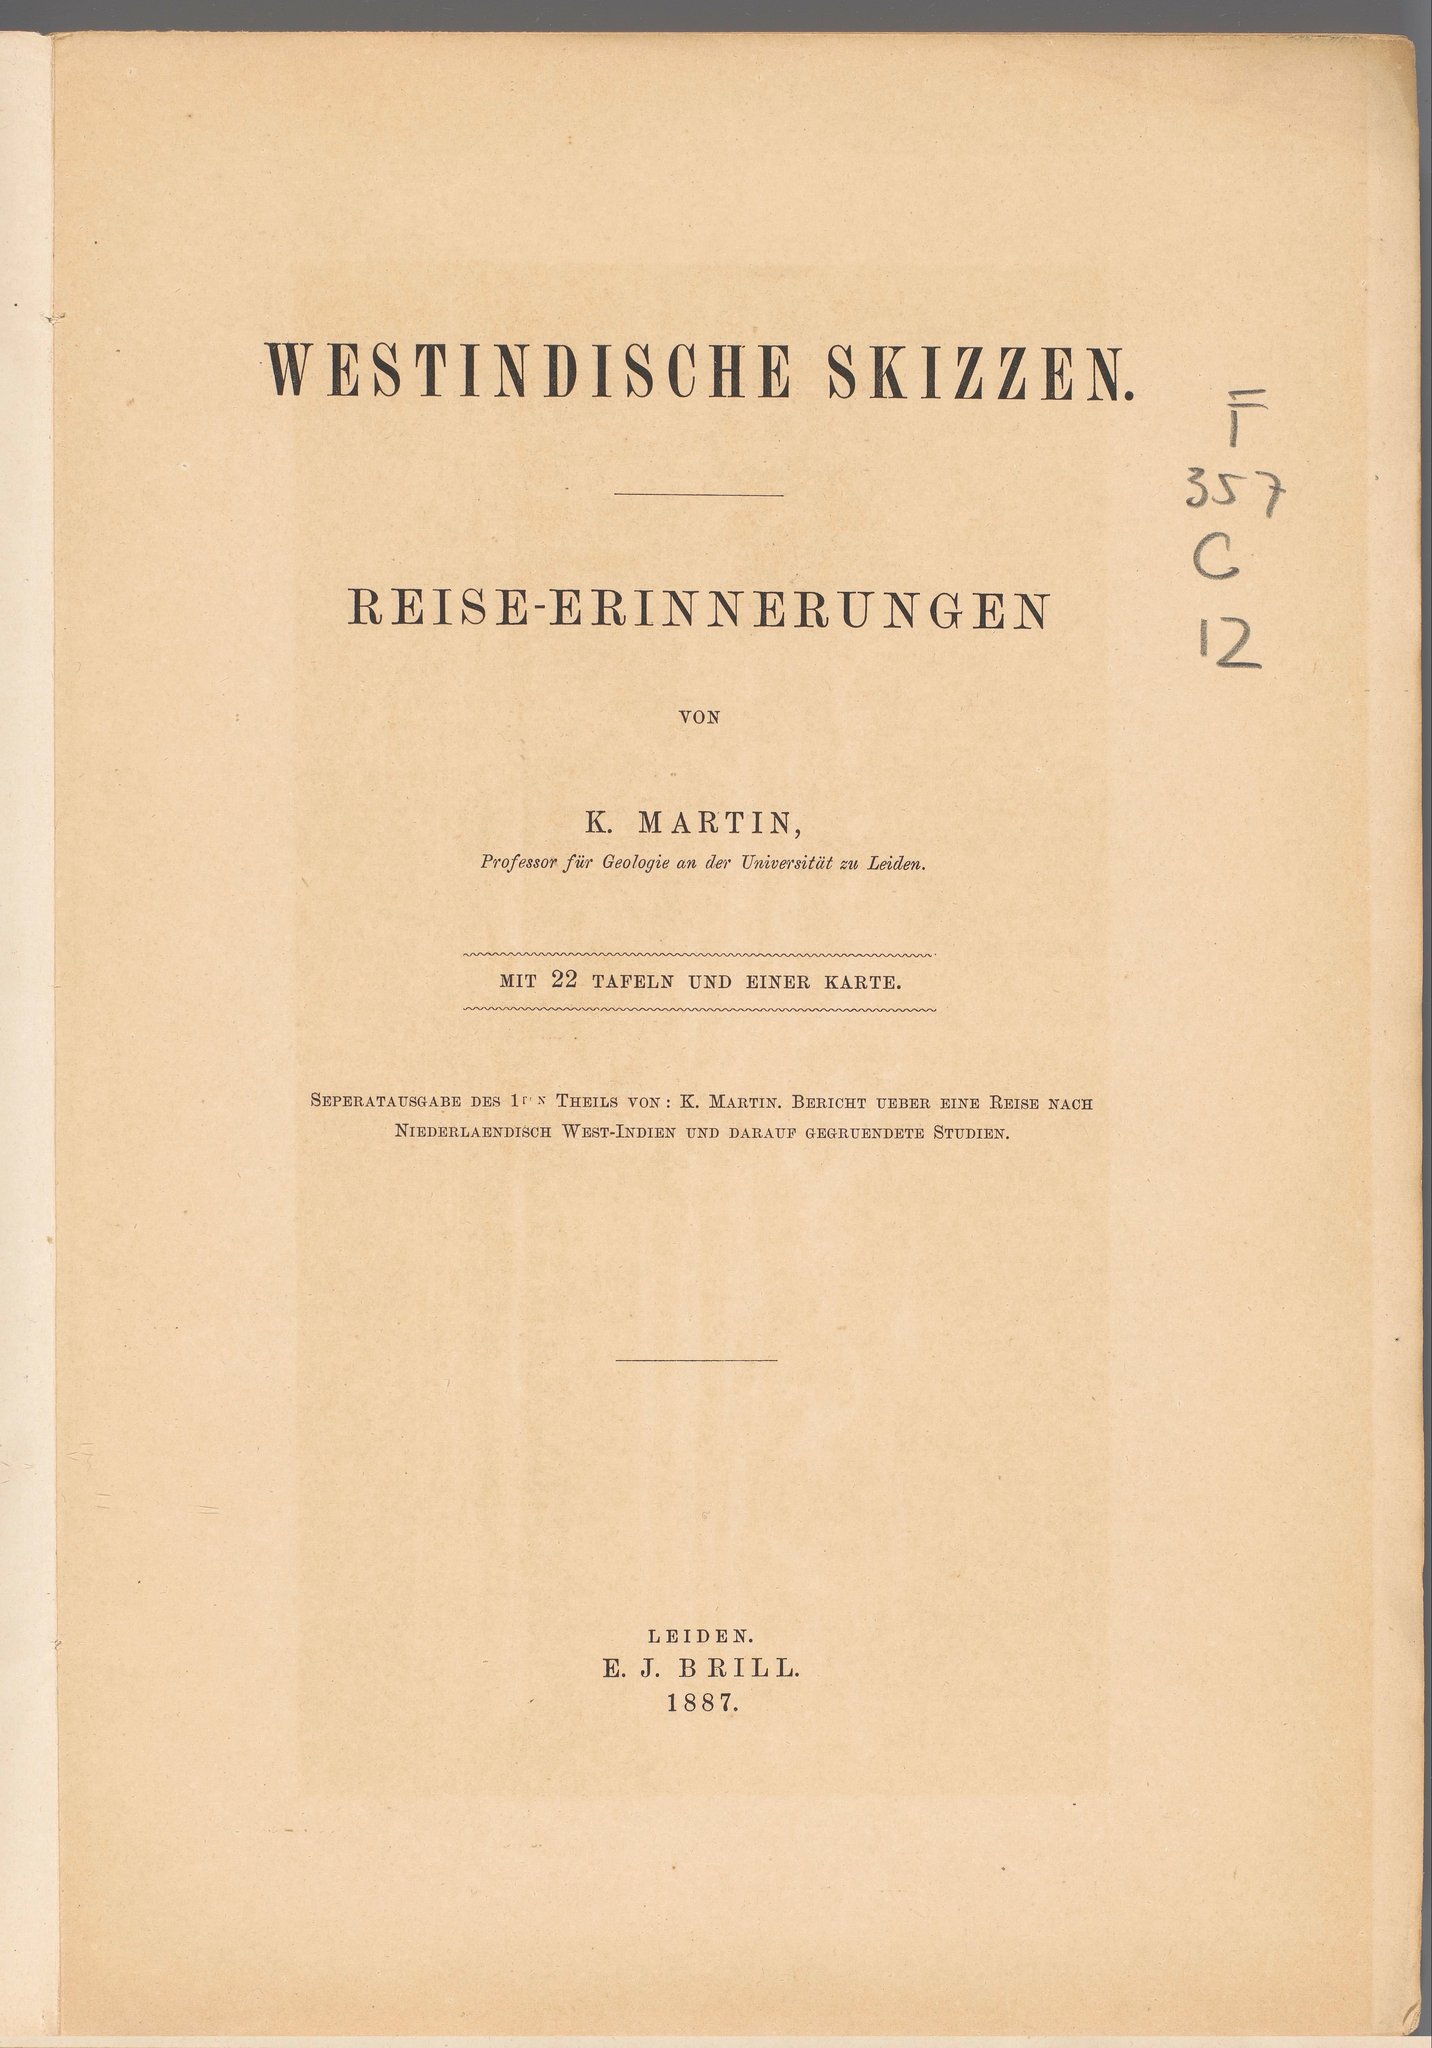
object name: book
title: Westindische Skizzen : Reise-Erinnerungen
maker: karl martin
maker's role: geoloog, professor, schrijver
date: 1887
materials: paper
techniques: photograph, printing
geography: leiden